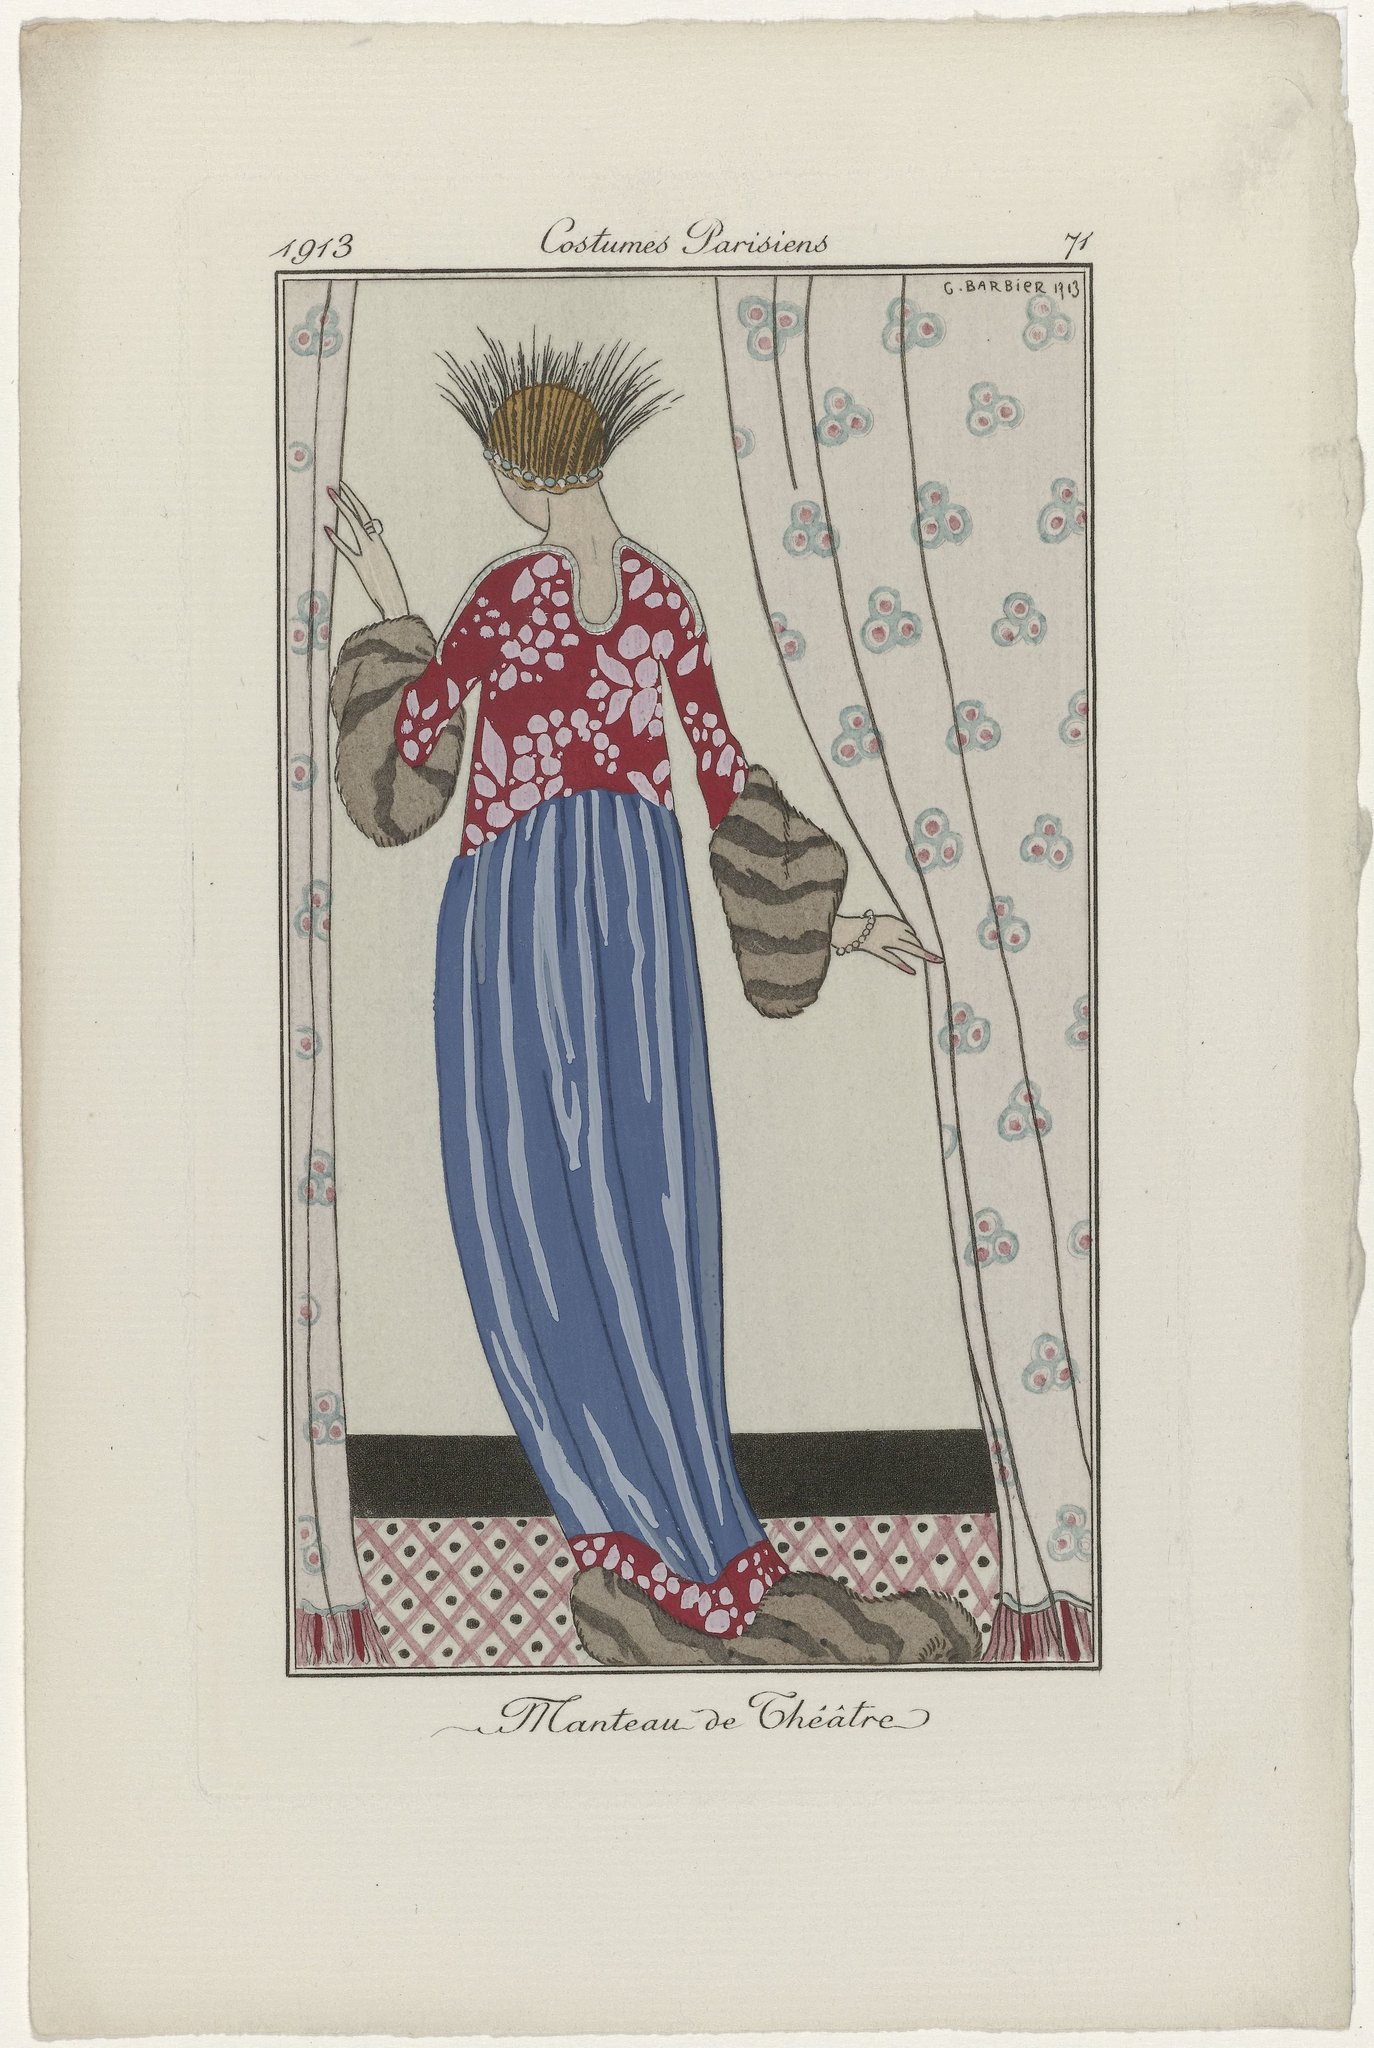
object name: fashion print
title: Journal des Dames et des Modes, Costumes Parisiens, 1913, No. 71 : Manteau de Théâtre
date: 1913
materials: paper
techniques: engraving, hand coloring, pochoir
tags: curtains, diadem, tiara (+ women's clothes), diadem, tiara (+ feathers used for clothes), coat (+ women's clothes), fashion plates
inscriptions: caption: ‘Manteau de Théâtre’, title: ‘Costumes Parisiens’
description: Vrouw, op de rug gezien, gekleed in een mantel voor in het theater. Hoofdband met opstaande veren. Prent uit het modetijdschrift Journal des Dames et des Modes (1912-1914).